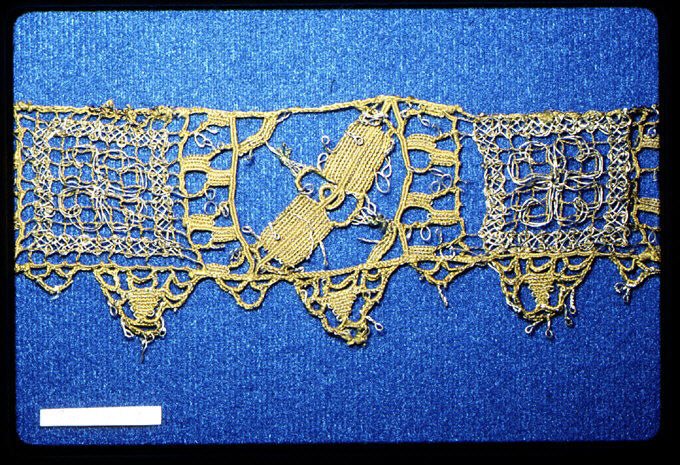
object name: piece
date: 1601-1700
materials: metal thread, silk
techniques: lace